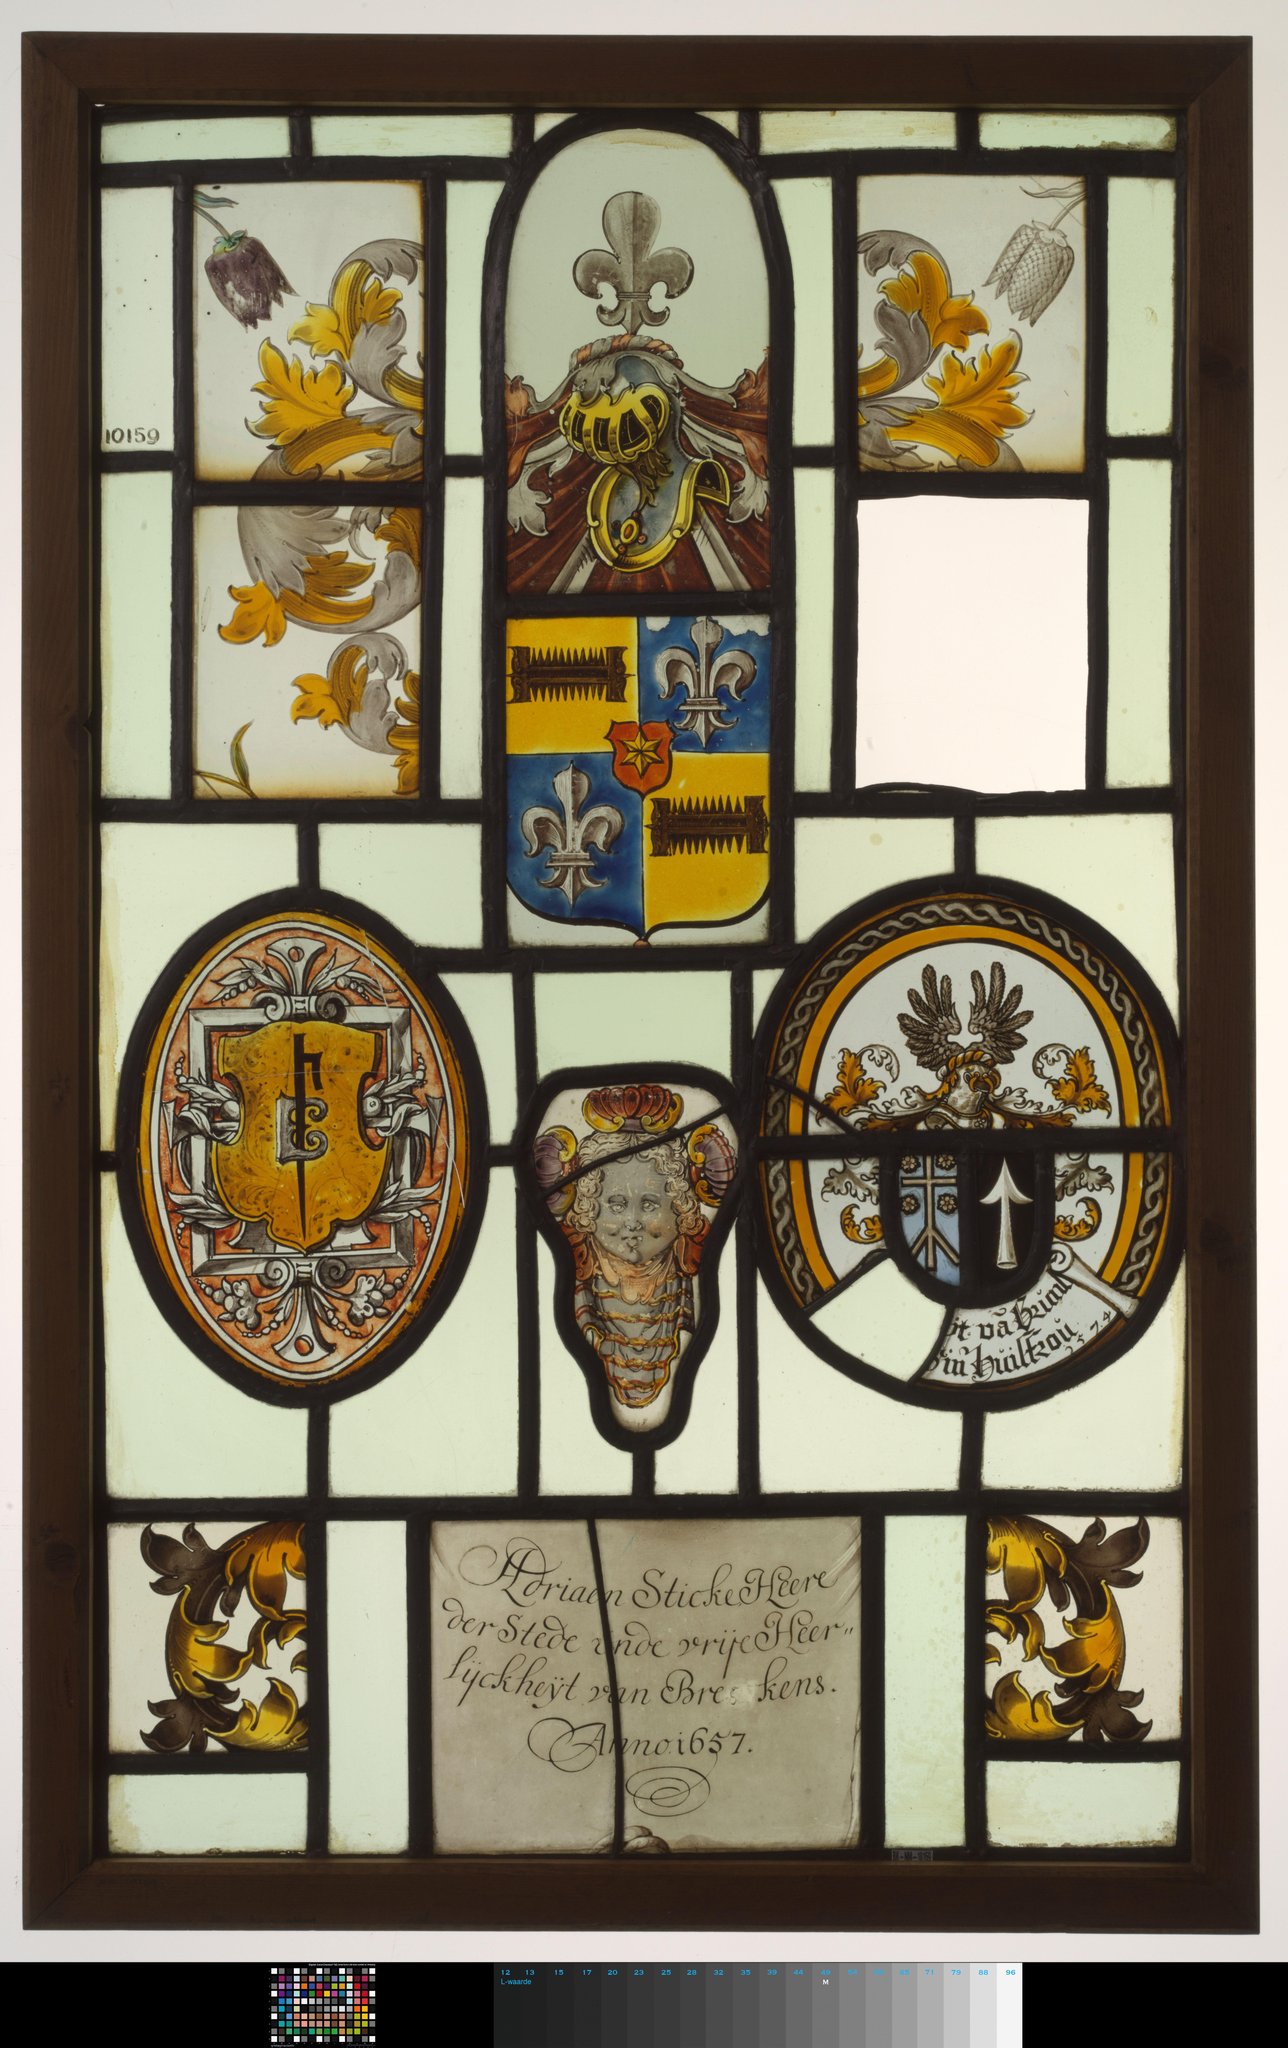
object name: wapenruit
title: Ruit met fragmenten van lambrequins, wapenruiten en een onderschrift "Adriaen Sticke, Heere der Stede ende vrije Heerlijckheyt van Breskens. Anno 1657"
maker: Anonymous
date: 1657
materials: glass, lead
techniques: leading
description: Ruit met fragmenten van lambrequins, wapenruiten en een onderschrift. Samengestelde ruit met diverse wapenfragmenten. In het onderschrift: Adriaen Sticke, Heere der Stede ende vrije Heerlijckheyt van Breskens. Anno 1657.